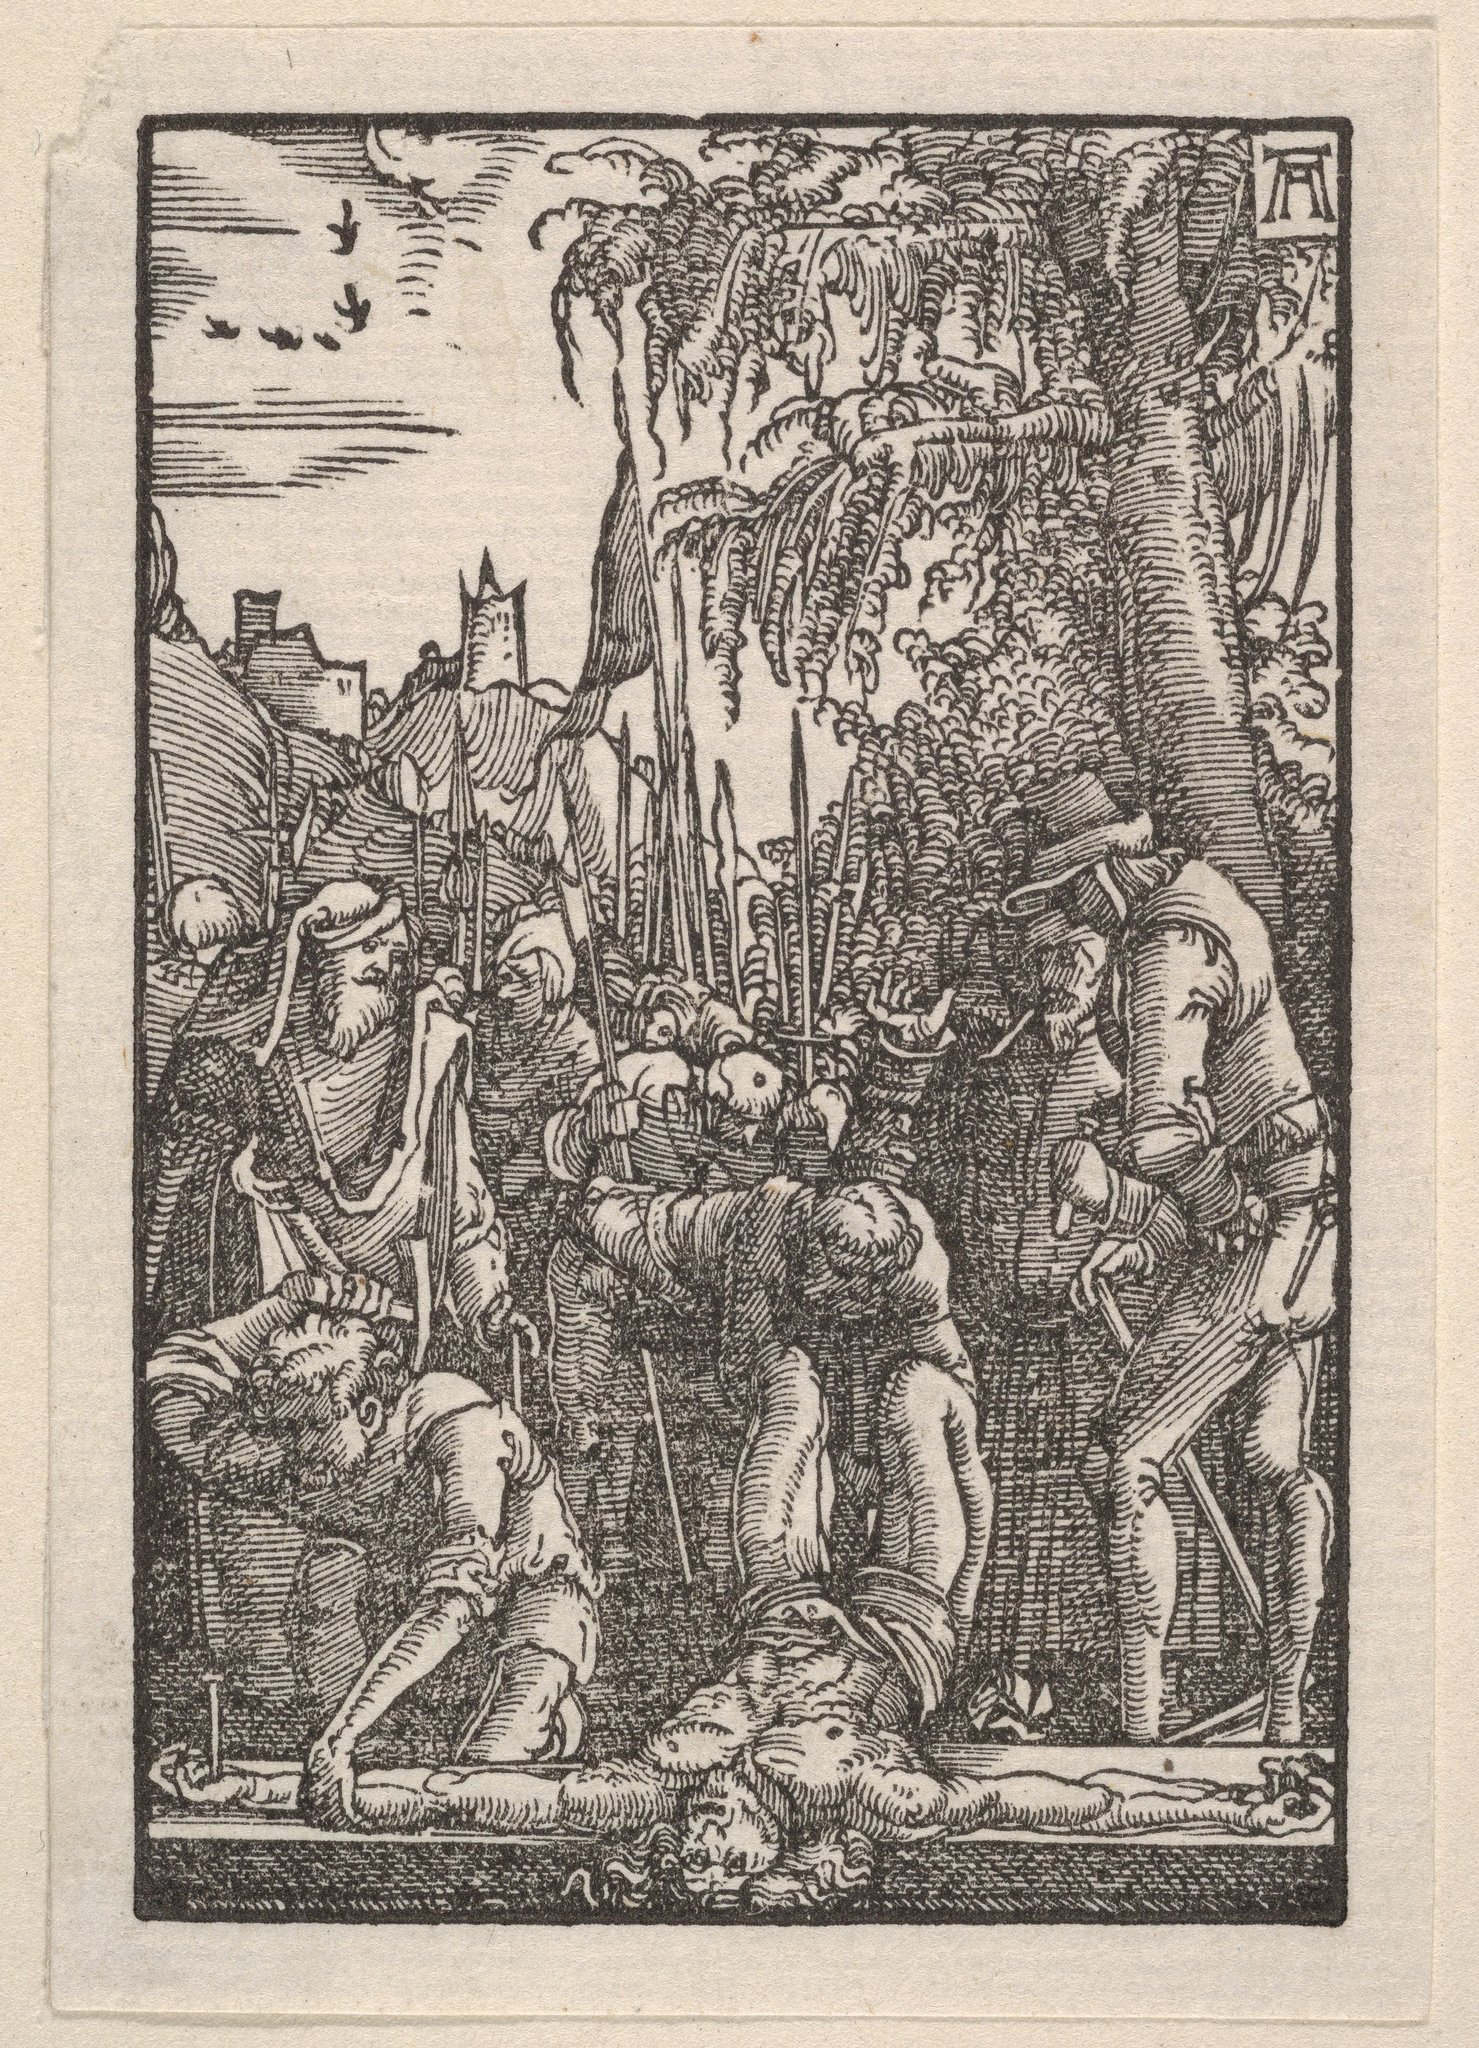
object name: print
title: Christ Nailed on the Cross, from "The Fall and Salvation of Mankind Through the Life and Passion of Christ"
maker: albrecht altdorfer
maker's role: artist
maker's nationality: german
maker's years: 1480-1538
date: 1513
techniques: woodcut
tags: soldiers,christ,crucifixion